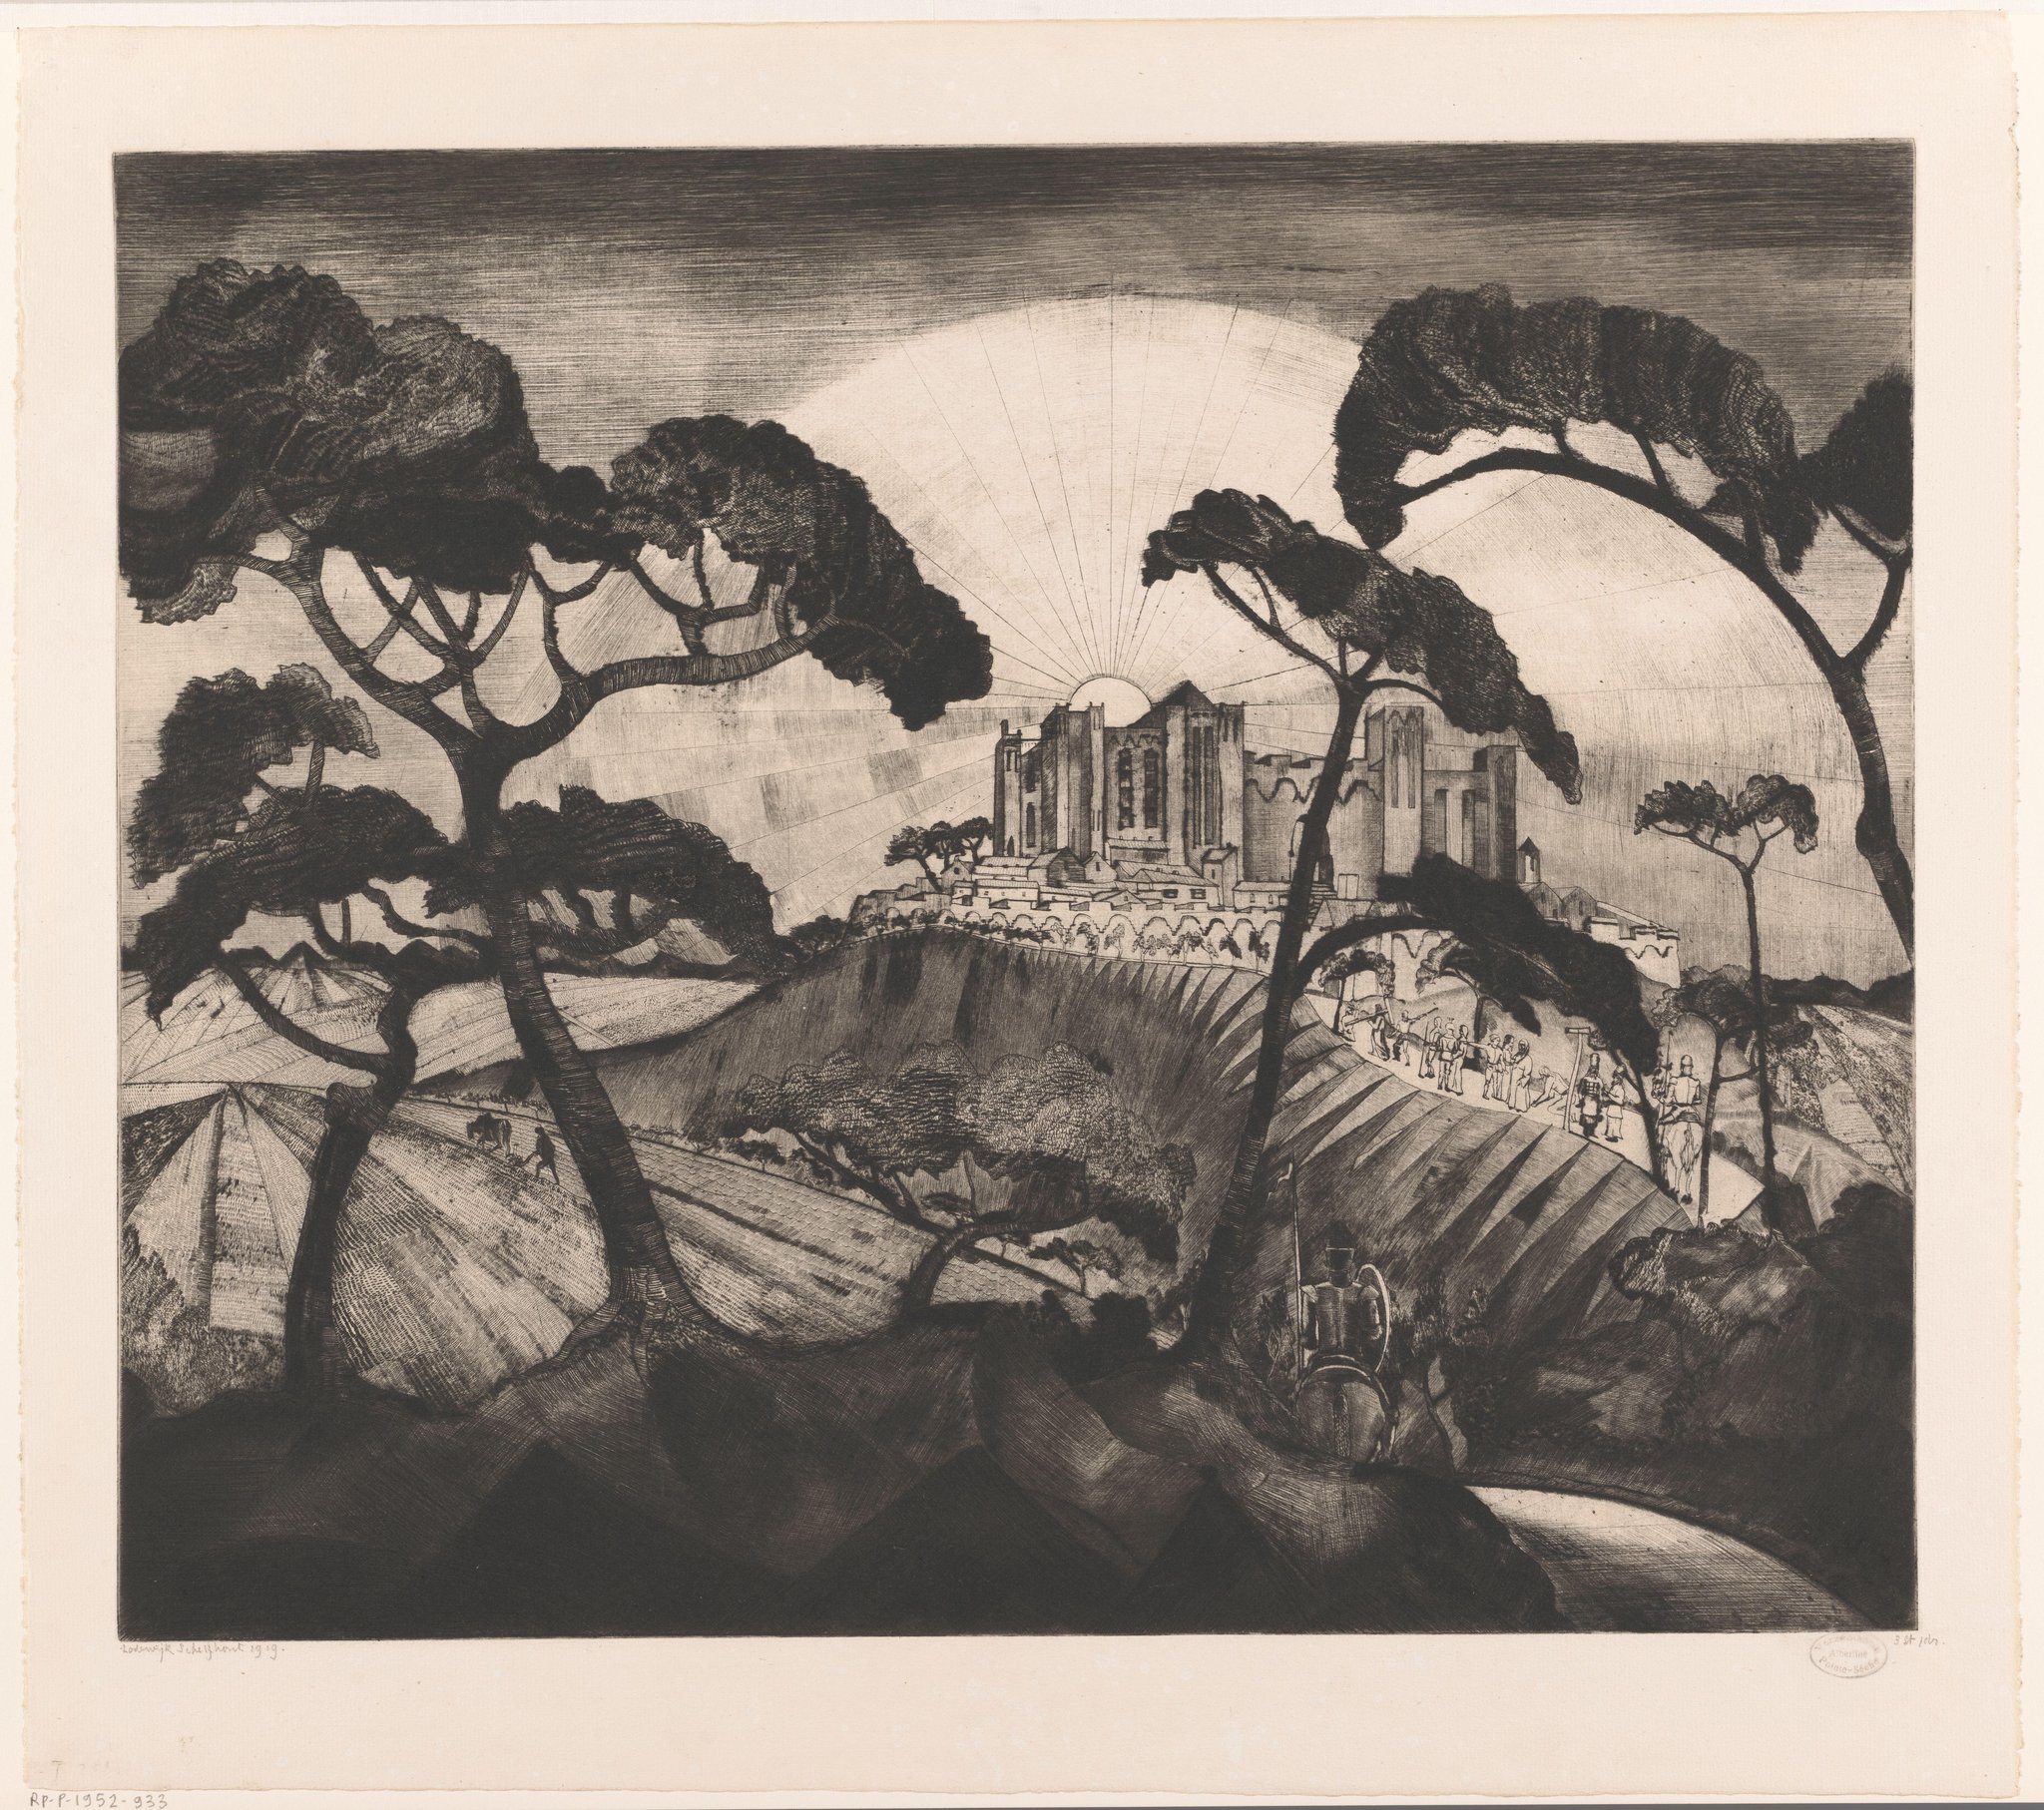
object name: print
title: Kasteel op een heuvel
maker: lodewijk schelfhout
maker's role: draughtsman, print maker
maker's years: 1881-1943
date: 1919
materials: paper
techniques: drypoint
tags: trees, landscape with tower or castle, sun as celestial body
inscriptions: collector's mark: Lugt 2760, collector's mark: Lugt 5i, collector's mark: Lugt 2228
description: Een heuvellandschap met akkers en een kasteel. Er leidt een pad naar het kasteel toe waarop zich een menigte mensen bevindt. Boven het kasteel de opgaande of ondergaande zon. Op de voorgrond parasolbomen.